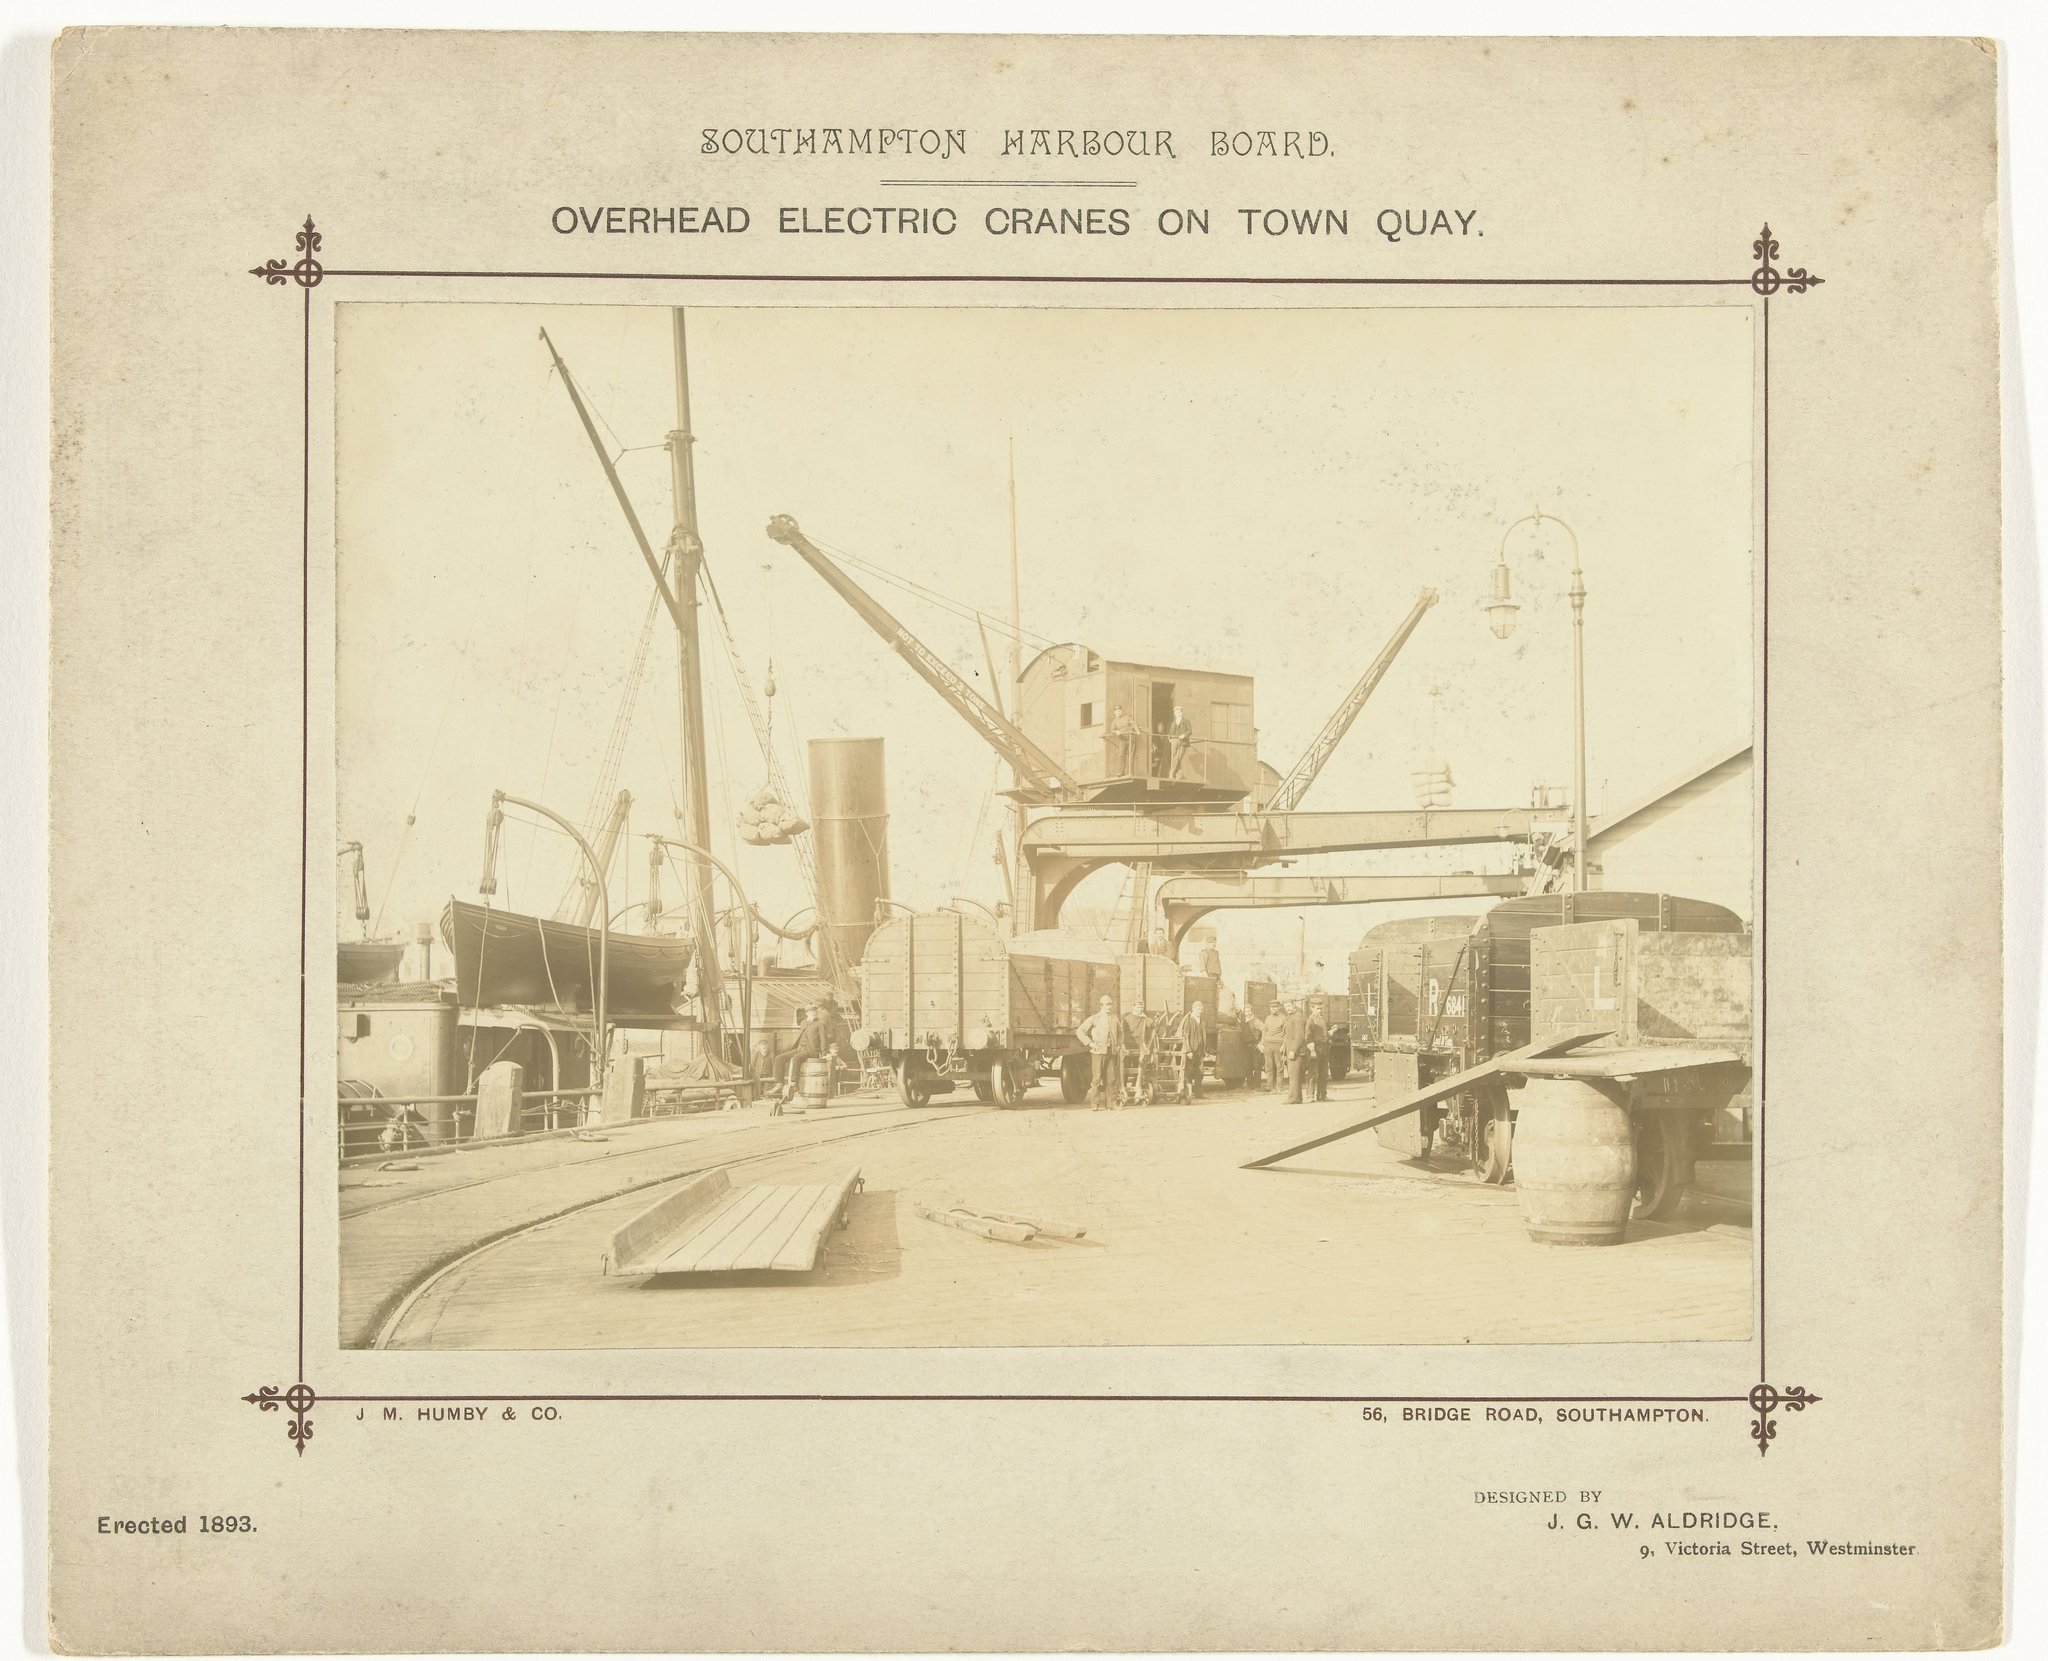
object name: photograph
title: Southampton Harbour Board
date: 1895-1905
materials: paper, cardboard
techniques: collodion silver print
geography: southampton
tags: dock crane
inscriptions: inscription: ‘ERECTED 1893./ DESIGNED BY/ J.G.W. ALDRIDGE,/ 9, Victoria Street, Westminster.’, address: ‘56, BRIDGE ROAD, SOUTHAMPTON.’